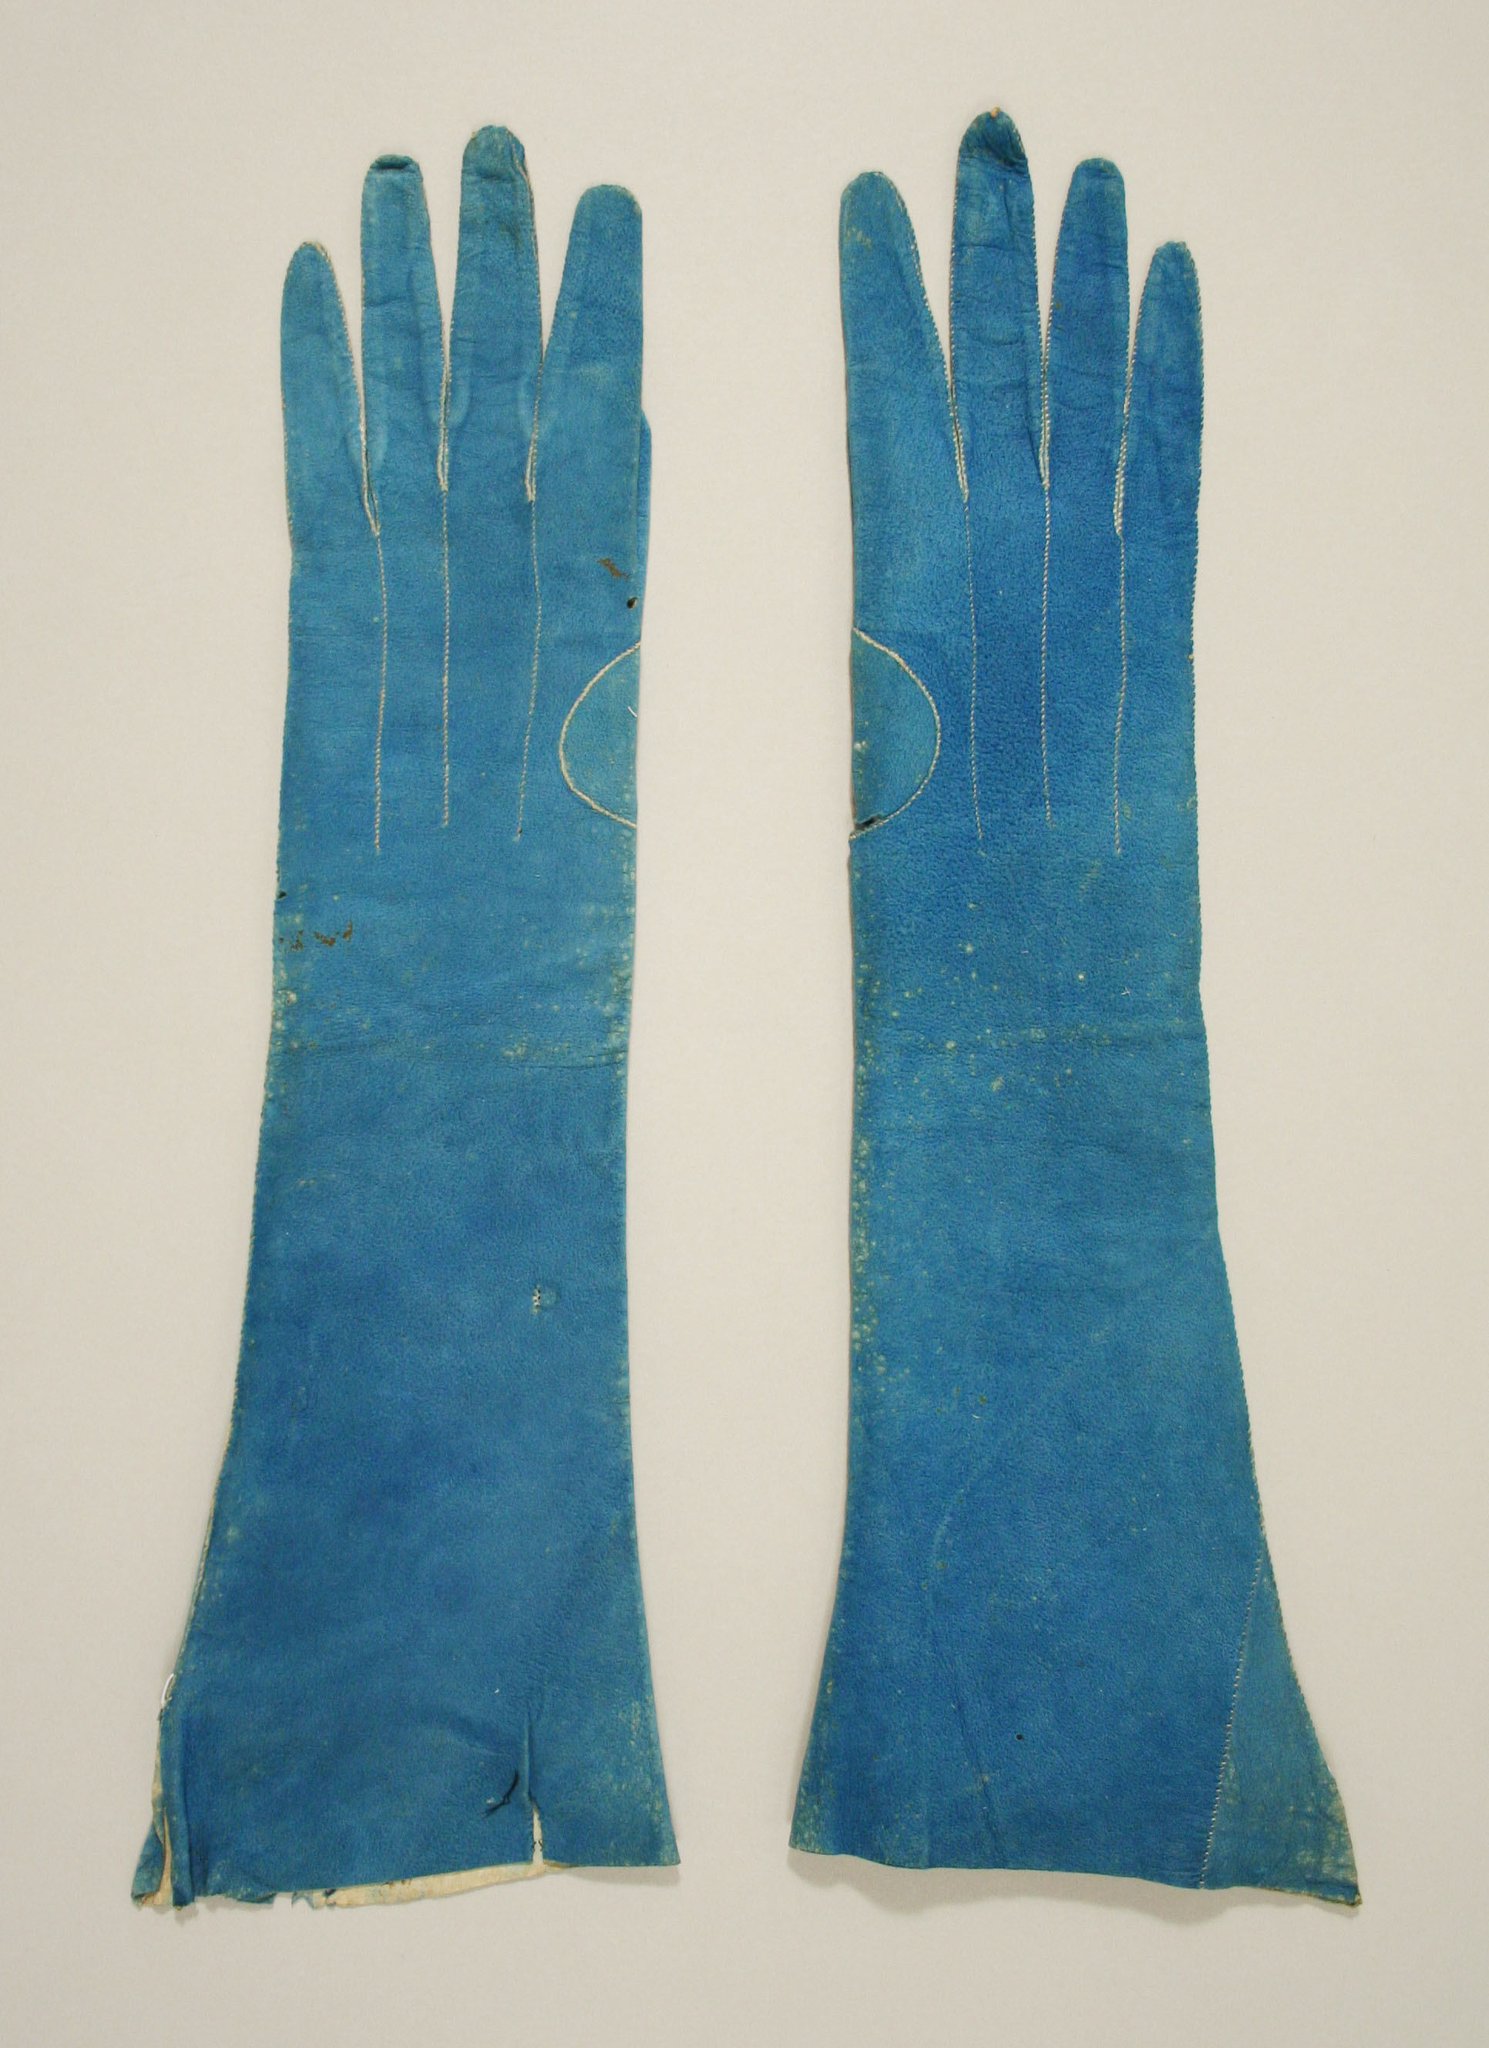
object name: glove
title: Gloves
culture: european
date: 1801-1833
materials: leather